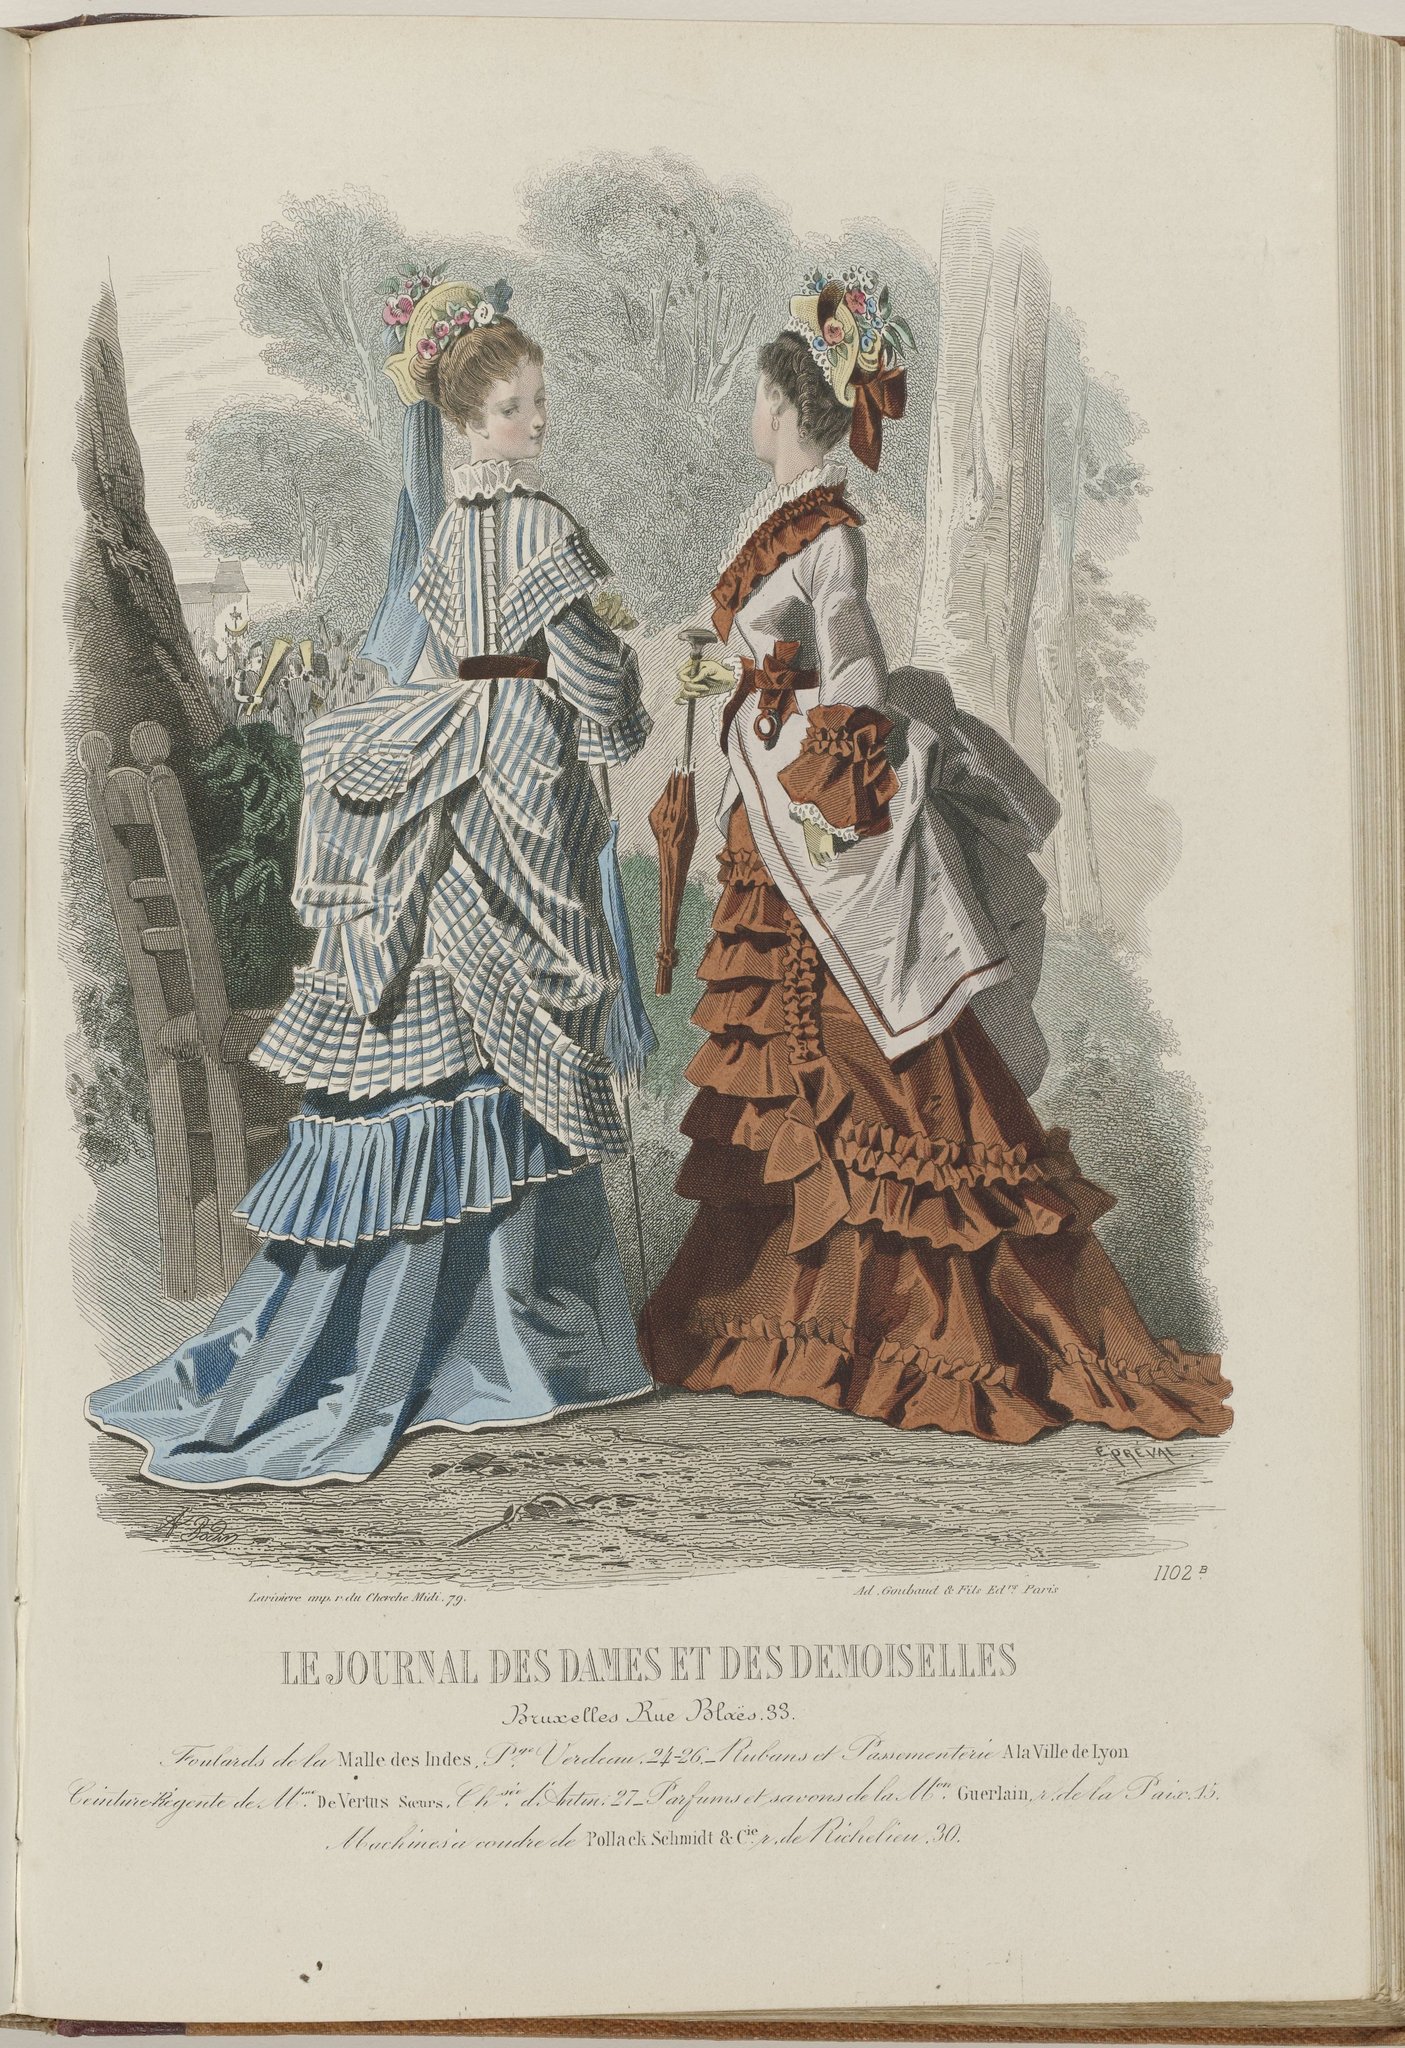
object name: fashion print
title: Journal des Dames et des Demoiselles, 15 Novembre 1872, No. 1102B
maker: a. bodin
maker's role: print maker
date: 1872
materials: paper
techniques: engraving, hand coloring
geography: brussels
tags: dress, gown: walking dress (+ women's clothes), dress, gown (visiting dress) (+ women's clothes), umbrella (+ women's clothes), head-gear (straw hat) (+ women's clothes), fashion plates, parasol, sunshade (+ women's clothes)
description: Toilettes de ville. Links een japon met blauwe rok met sleep en een tuniek van gestreepte foulard, met geplisseerde strook. Strohoedje met bloemetjes. Rechts een japon in kastanjebruin met stroken aan de rok. Tuniek van grijze stof, afgezet met een kanstanjebruine strook. Medicikraag. Strohoedje met bloemen. In onderschrift enkele adressen voor stoffen, accessoires en andere producten. Prent uit Le Journal des Dames et des Demoiselles (1841-1902).